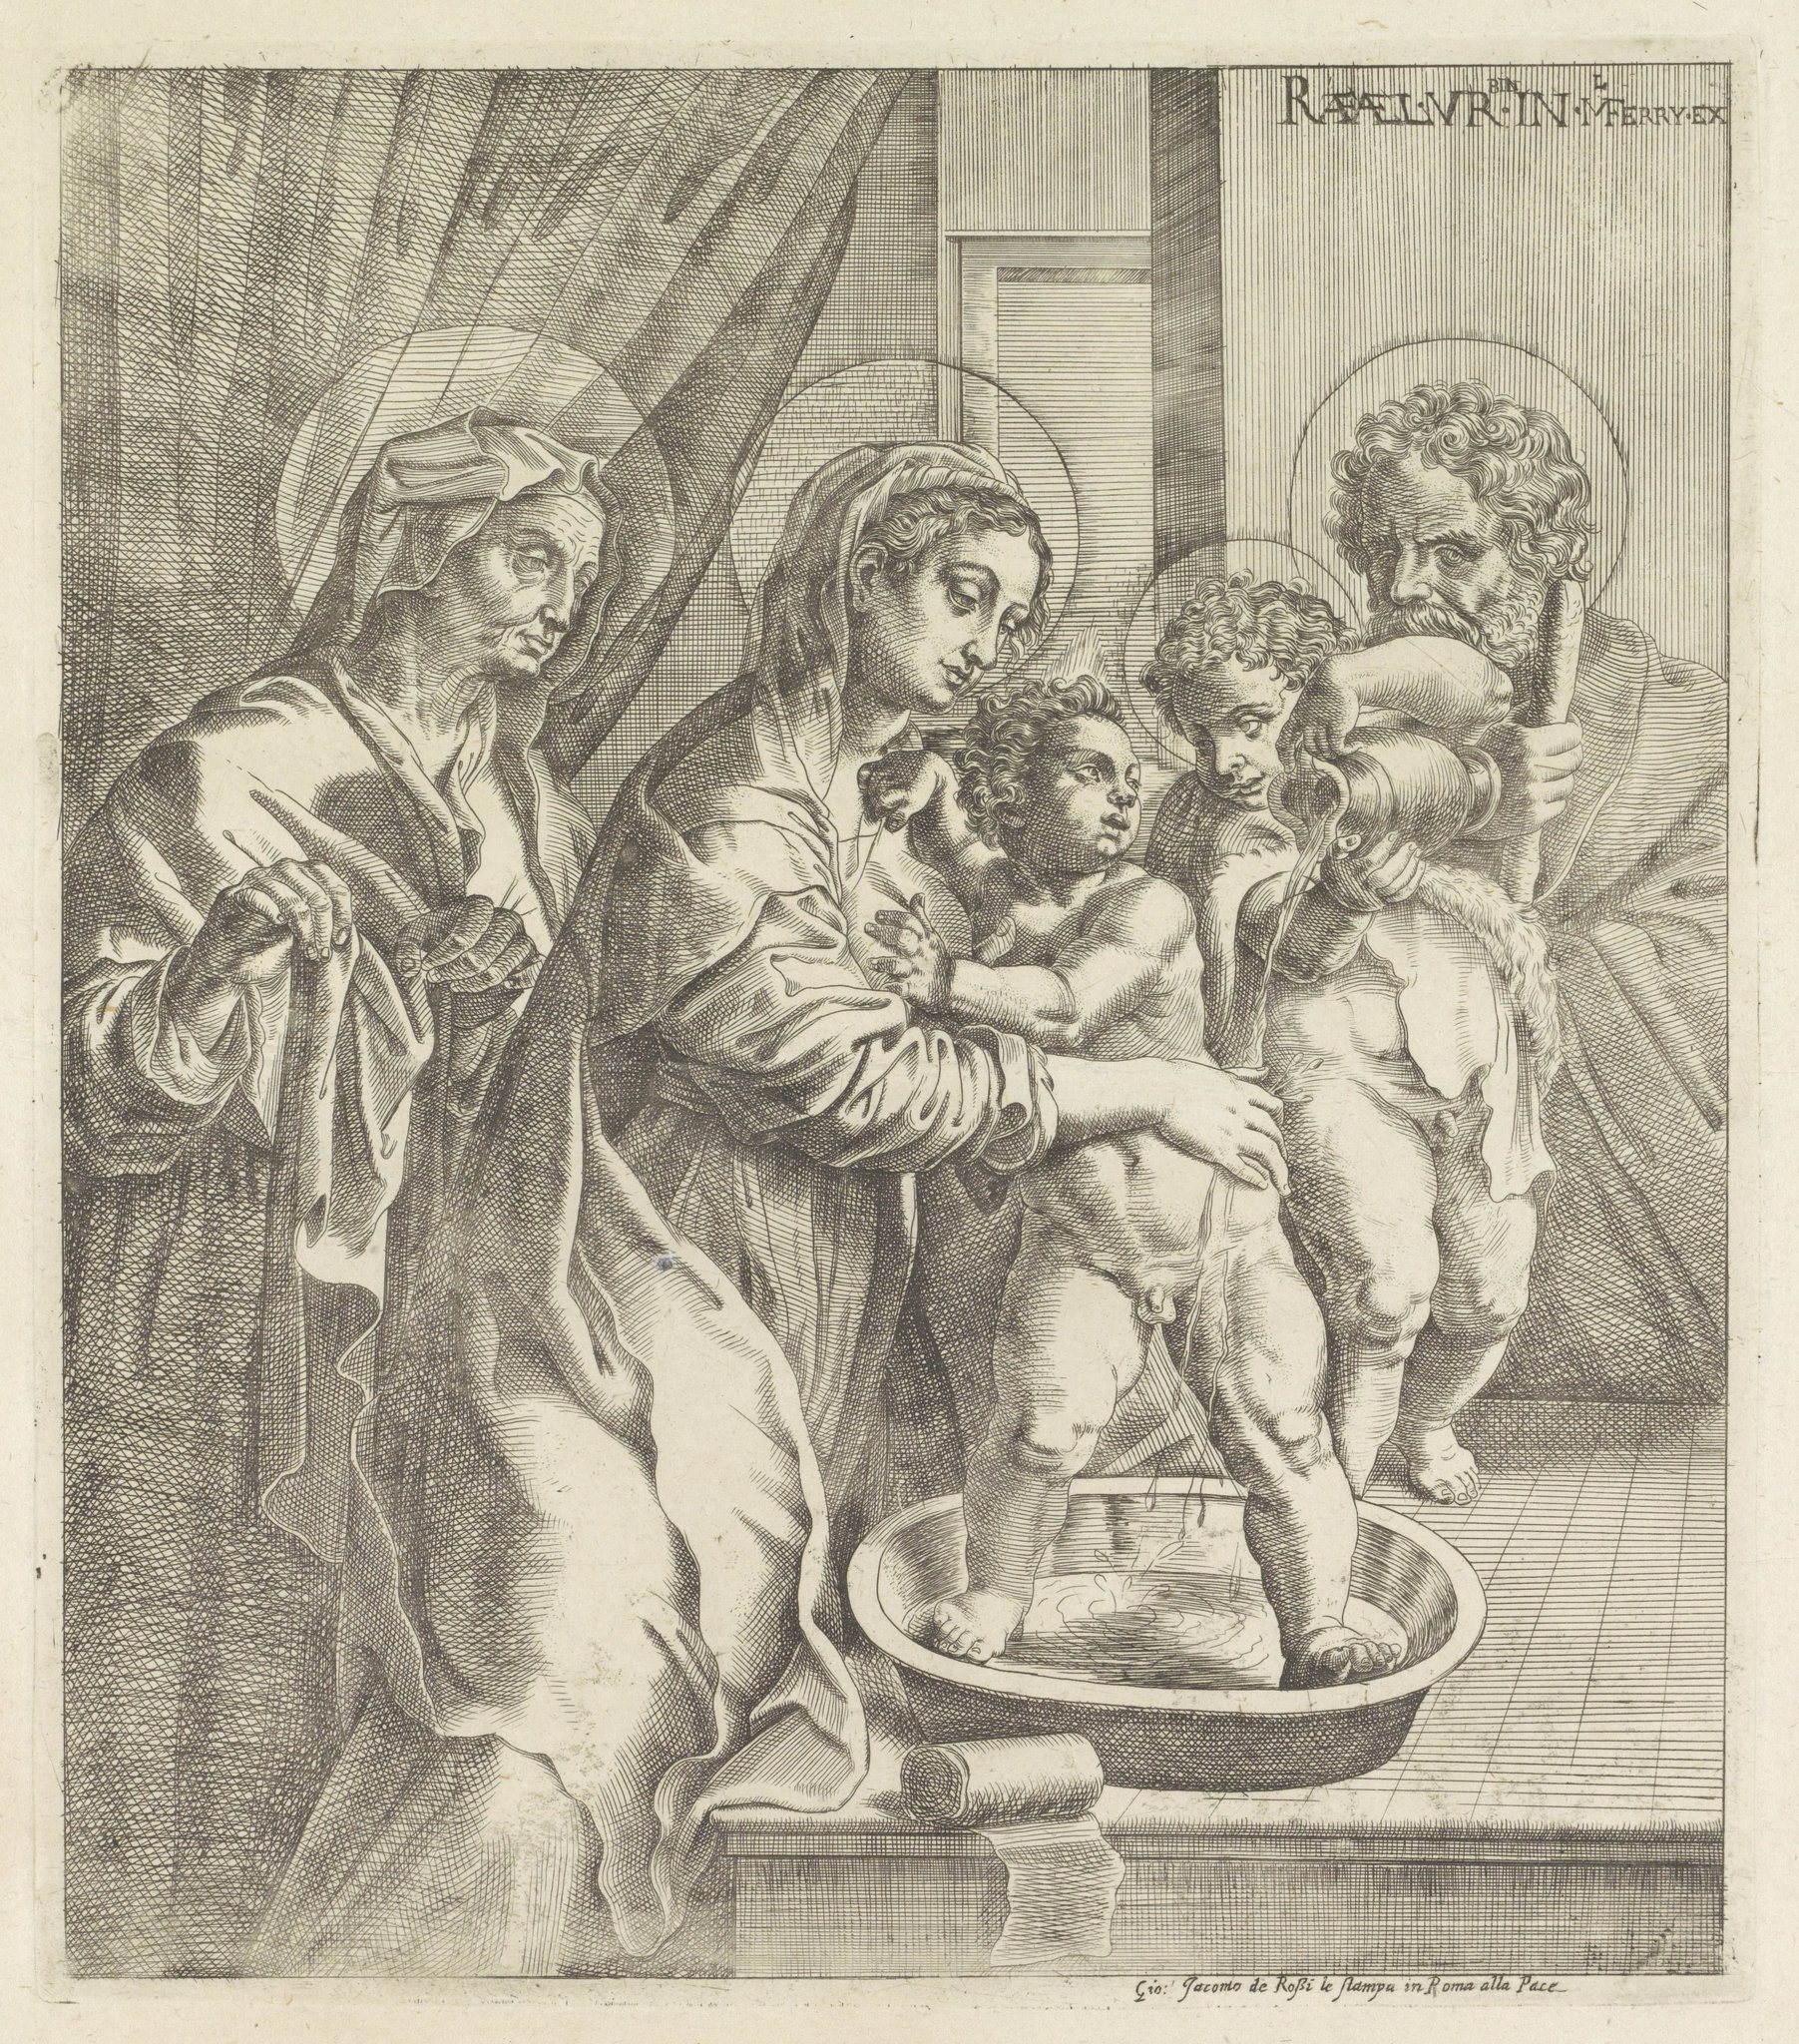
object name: print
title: Maria en de jonge Johannes de Doper wassen het Christuskind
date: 1637-1691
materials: paper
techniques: engraving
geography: italy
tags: mary, the christ-child and john the baptist, elisabeth present, washing and changing baby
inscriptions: collector's mark: Lugt 2228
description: Maria en de jonge Johannes de Doper wassen het Christuskind. Op de achtergrond staan Jozef en Elisabet.